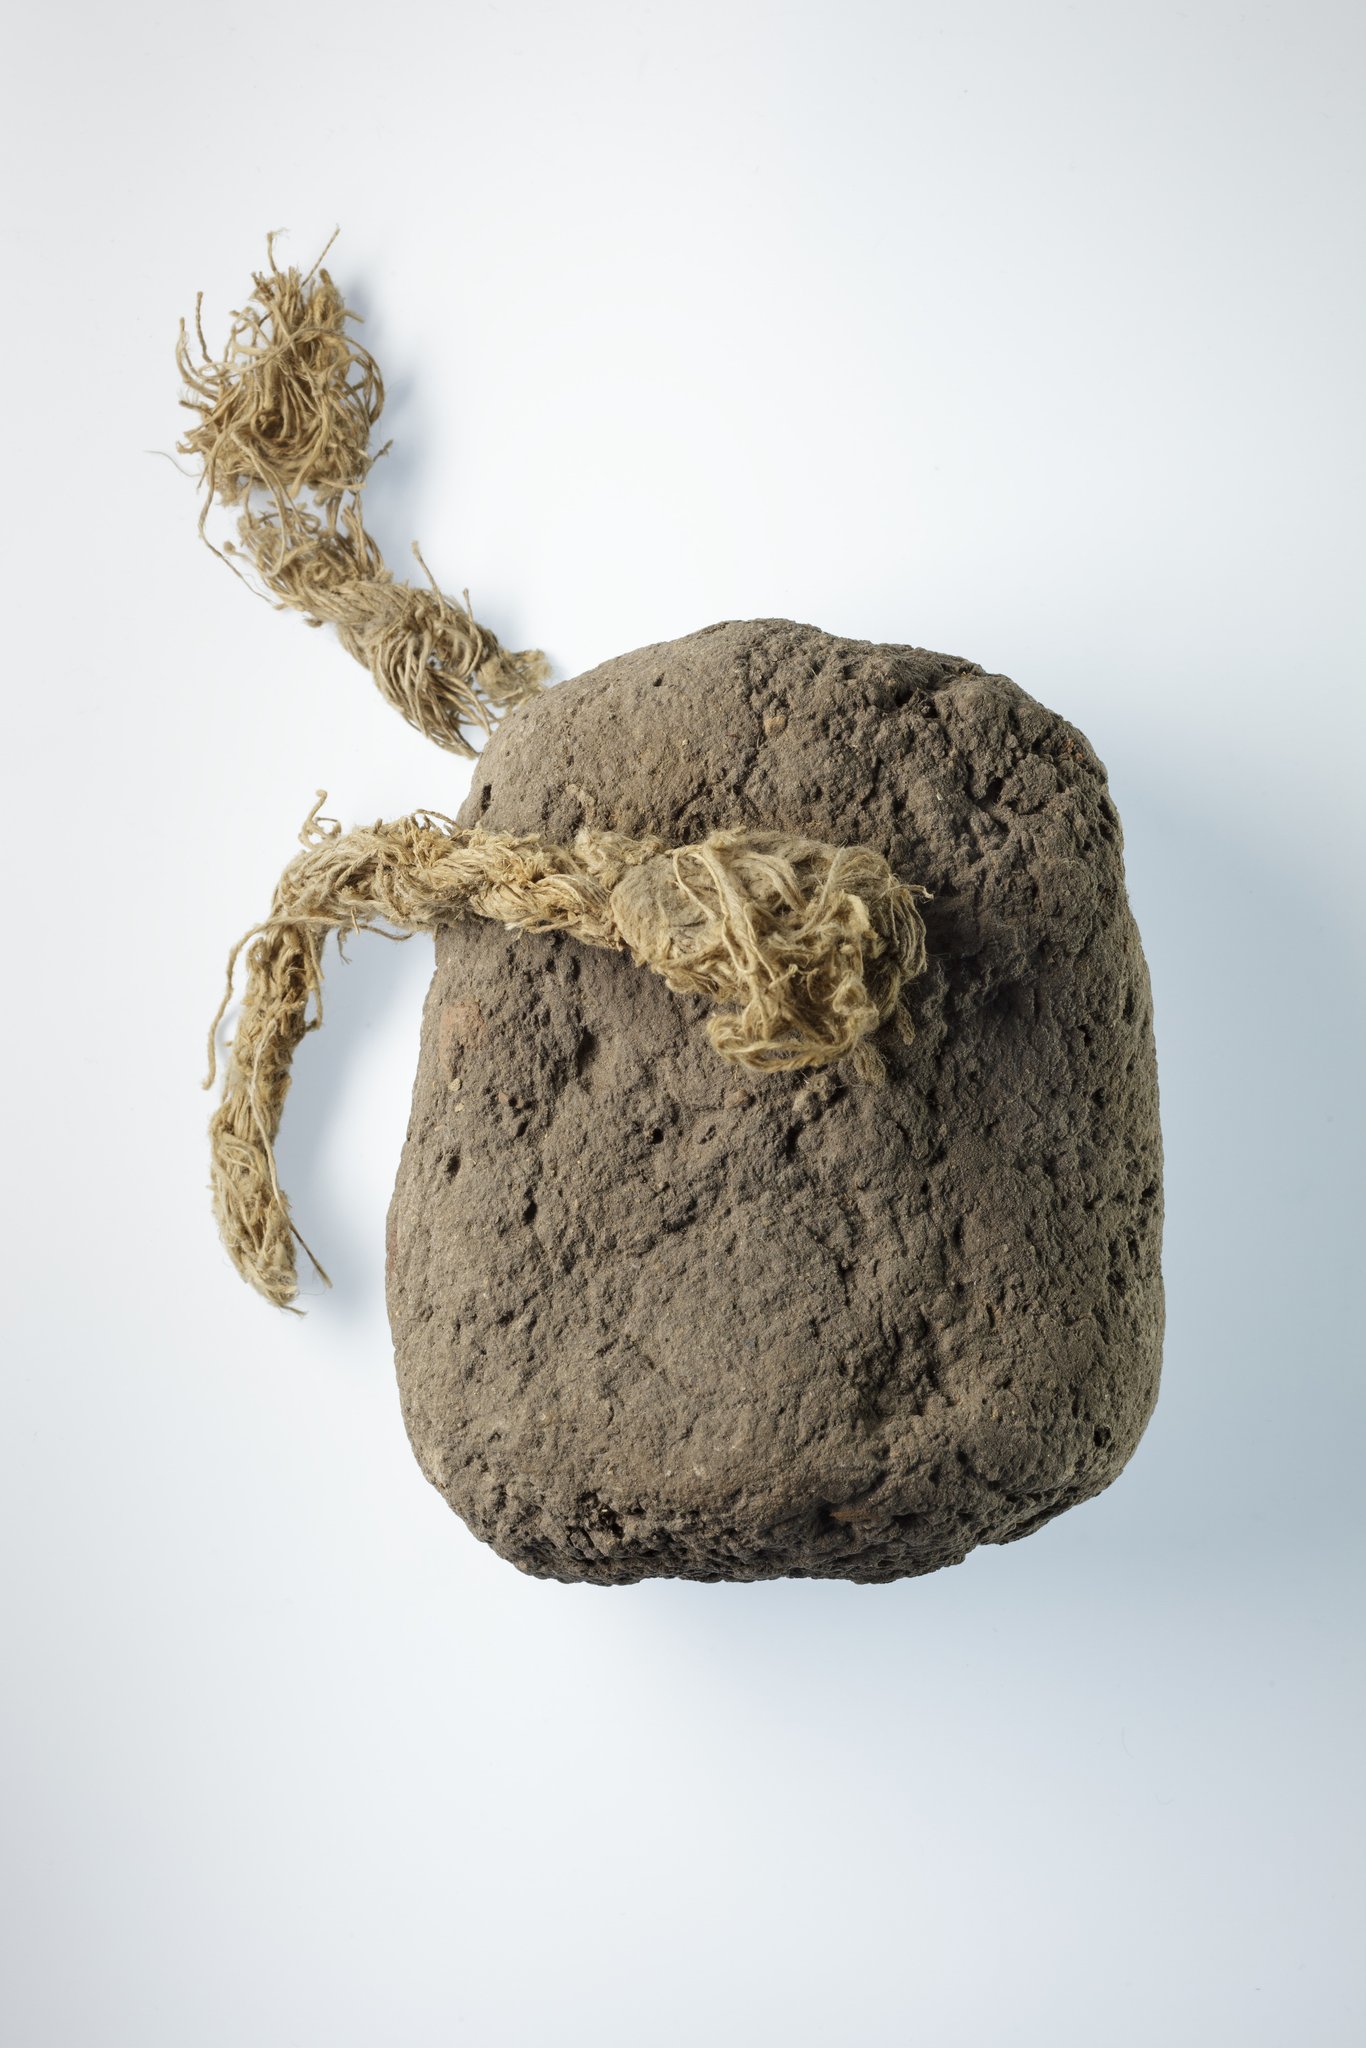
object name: loom weight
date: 1295-1070 BCE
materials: mud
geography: egypt